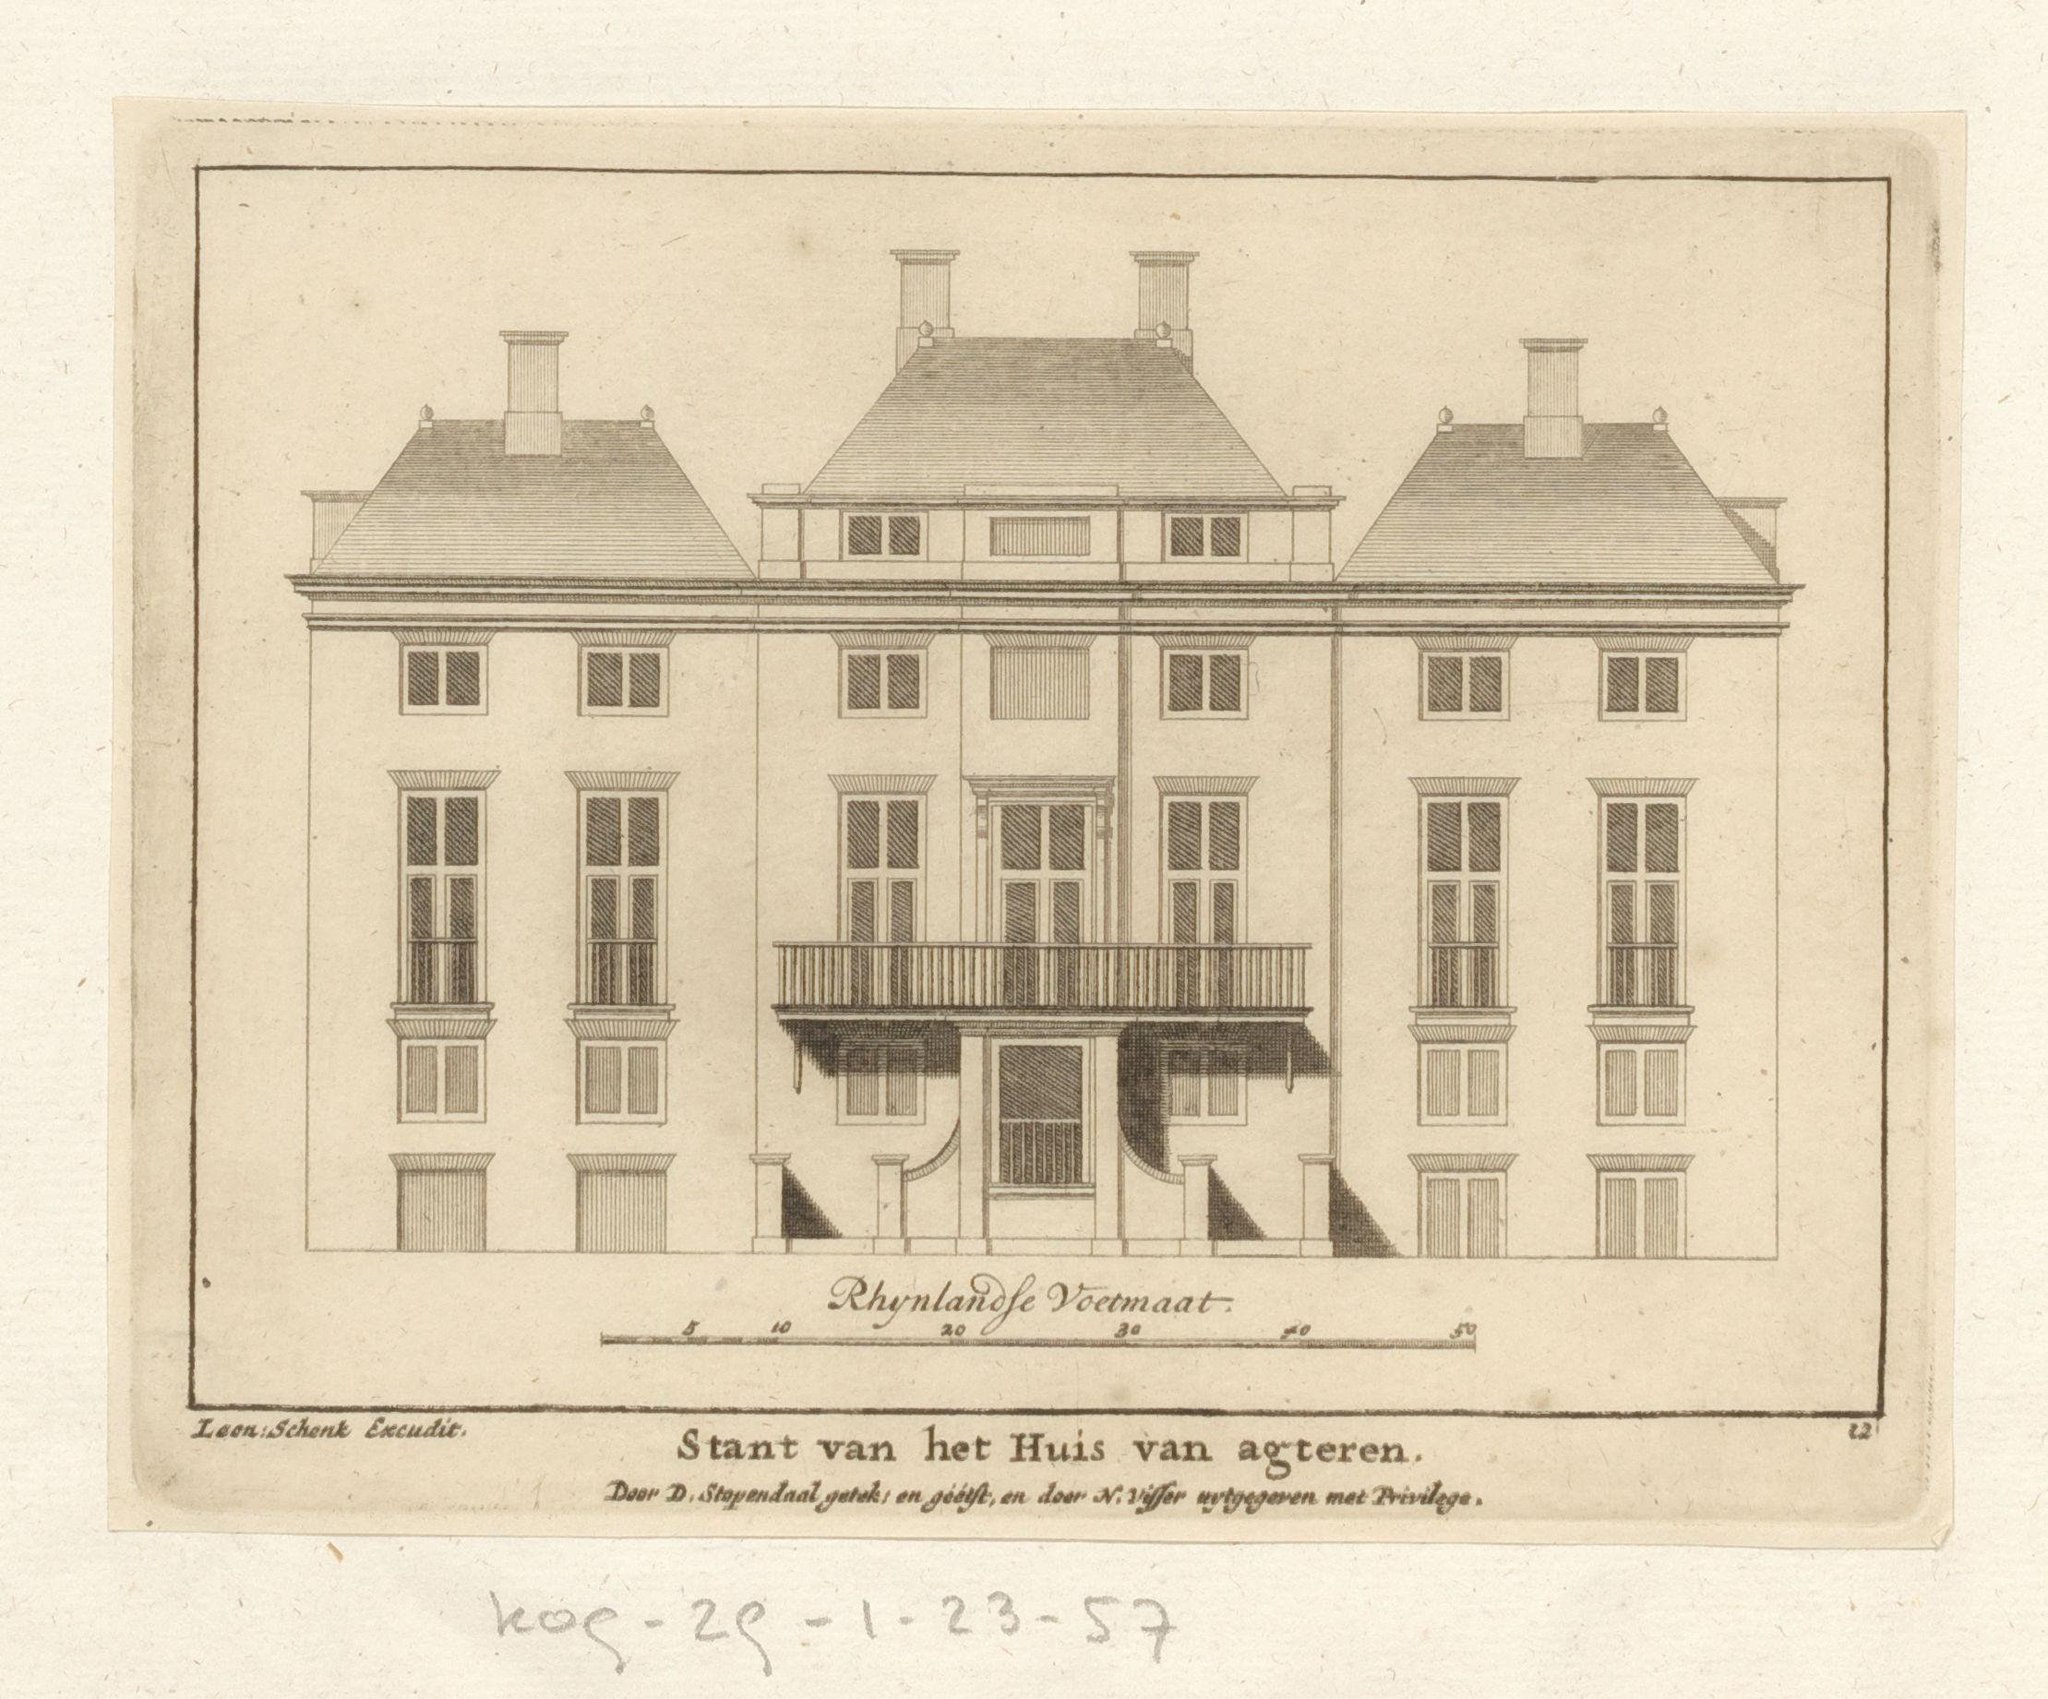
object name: print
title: Verscheyde schoone en vermaakelyke gezigten, in de Hofstede van Clingendaal gelegen by 's Gravenhage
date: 1706-1767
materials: paper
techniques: engraving, etching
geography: amsterdam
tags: exterior ~ architectural design or model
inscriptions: collector's mark: Lugt 1641, stamp, stamp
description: De achtergevel van Huis Clingendael te Den Haag. Onderaan een schaalverdeling. Onderwerpsrubrieken binnen de Atlas Zeden en Gewoonten: Zeden en Gewoonten in Engeren Zin, De Woning. Kastelen en buitenplaatsen. Holland.